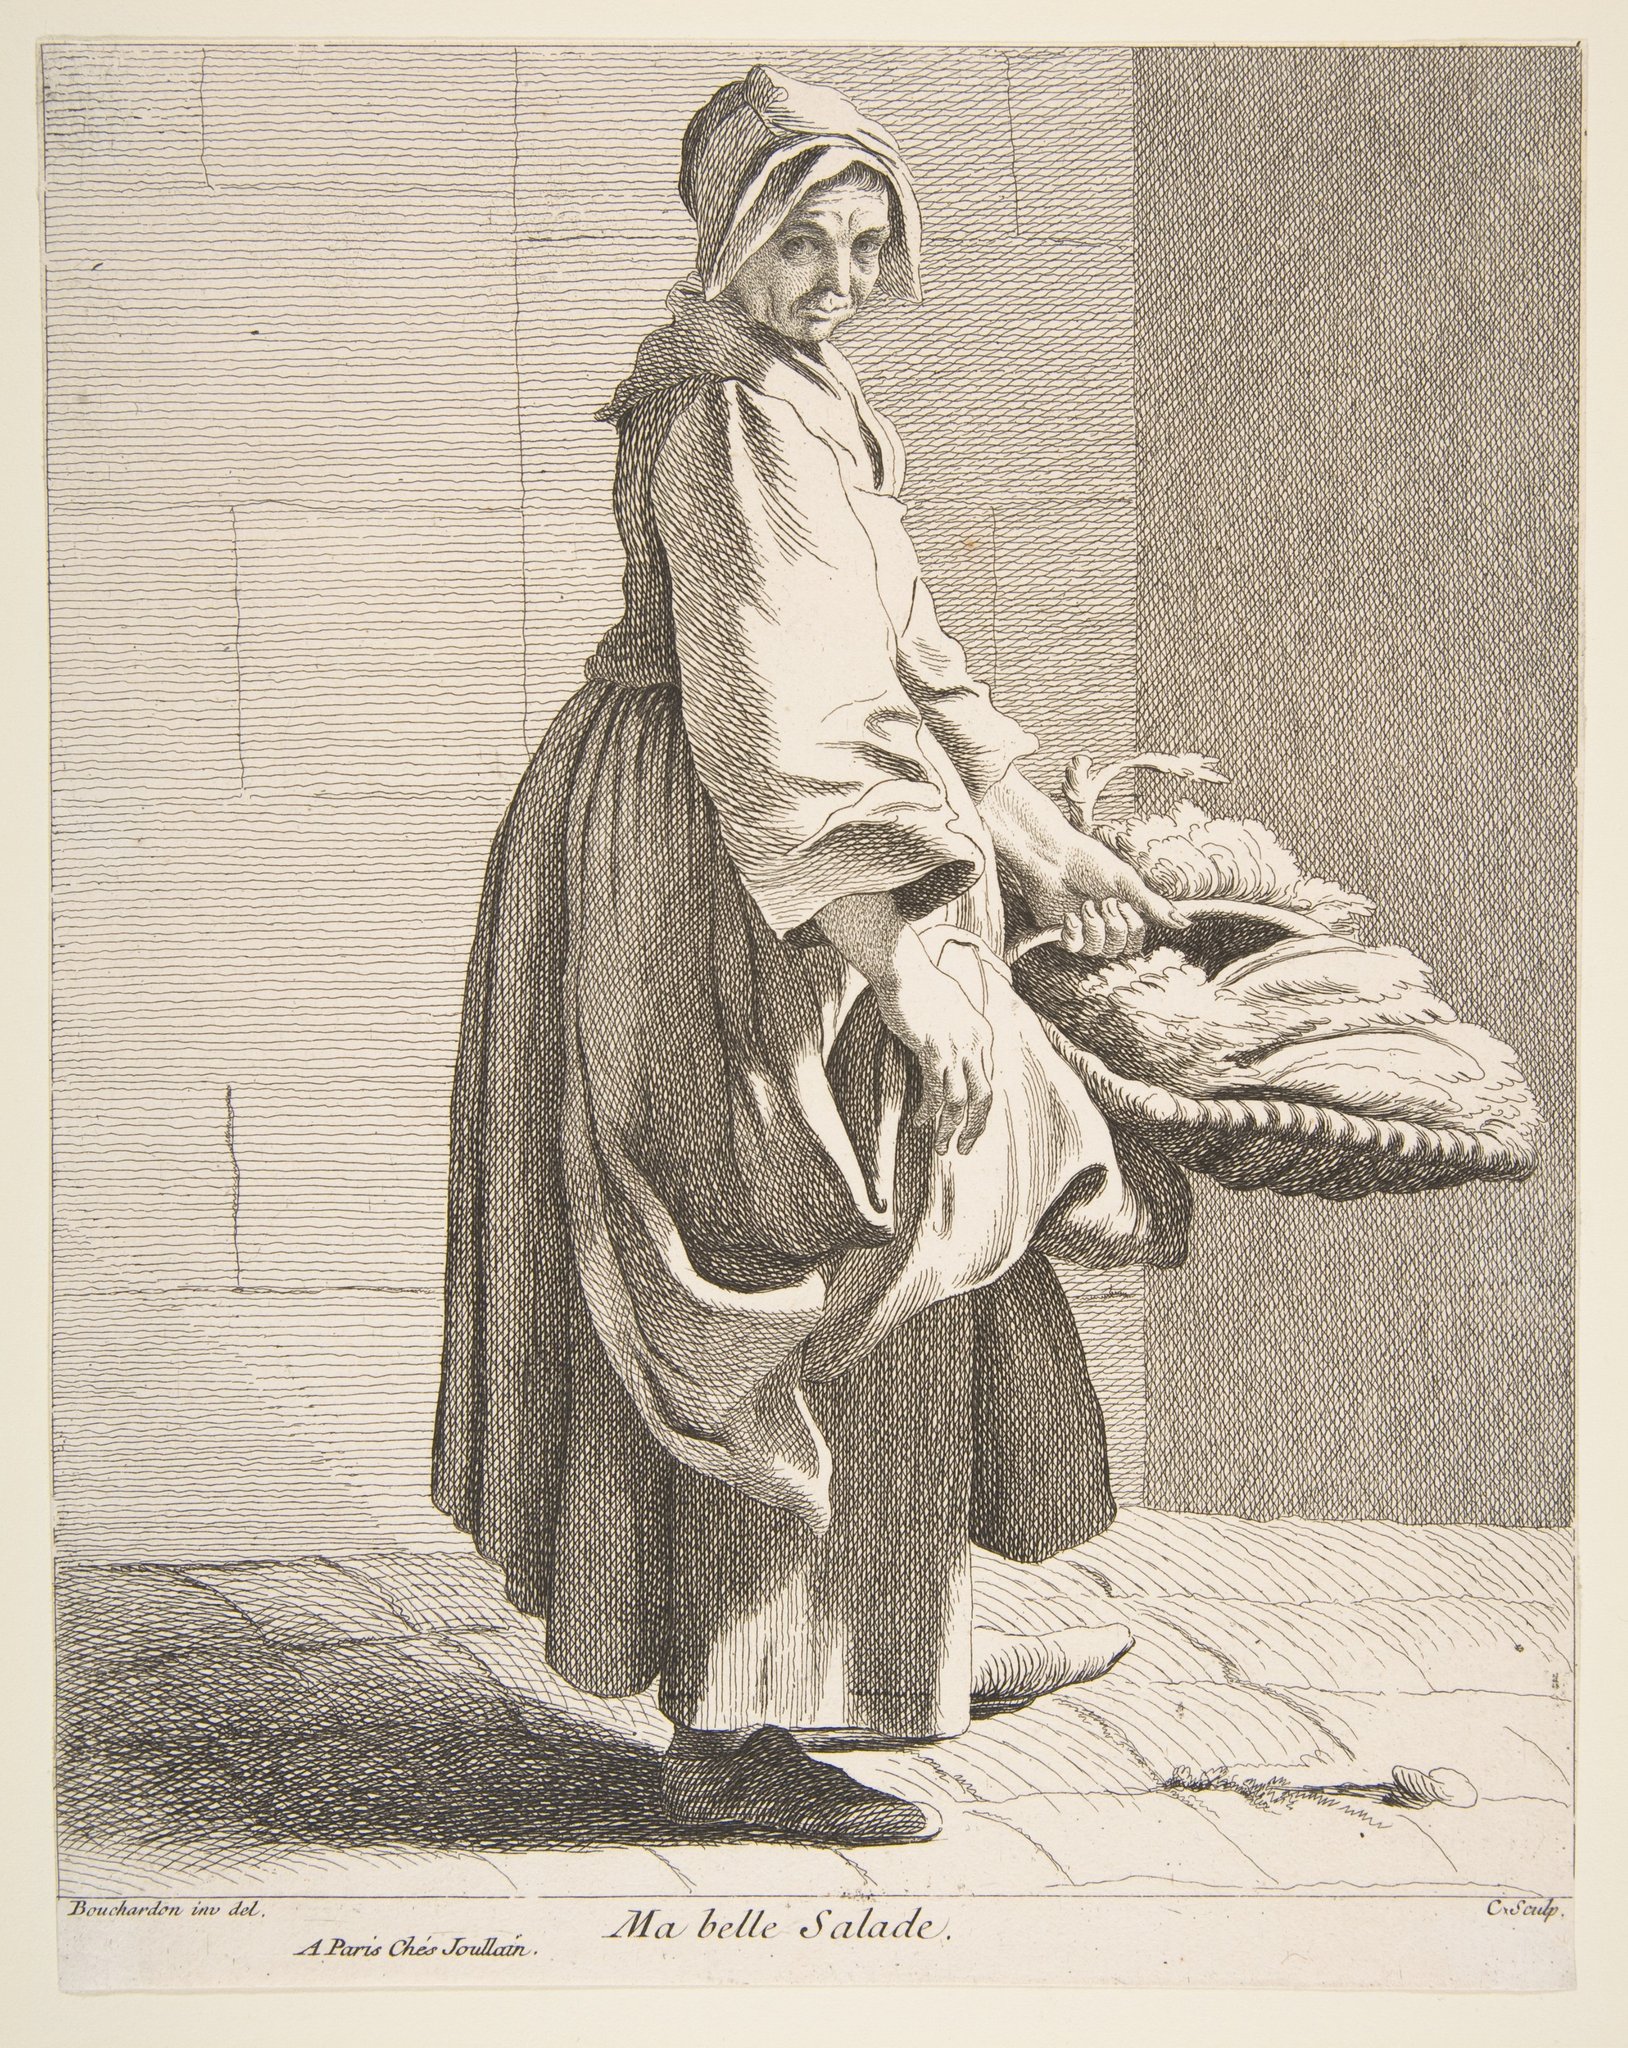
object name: print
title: Lettuce Seller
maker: anne claude philippe de tubières, comte de caylus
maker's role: artist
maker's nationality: french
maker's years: 1692-1765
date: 1742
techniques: engraving, etching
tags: vegetables,women